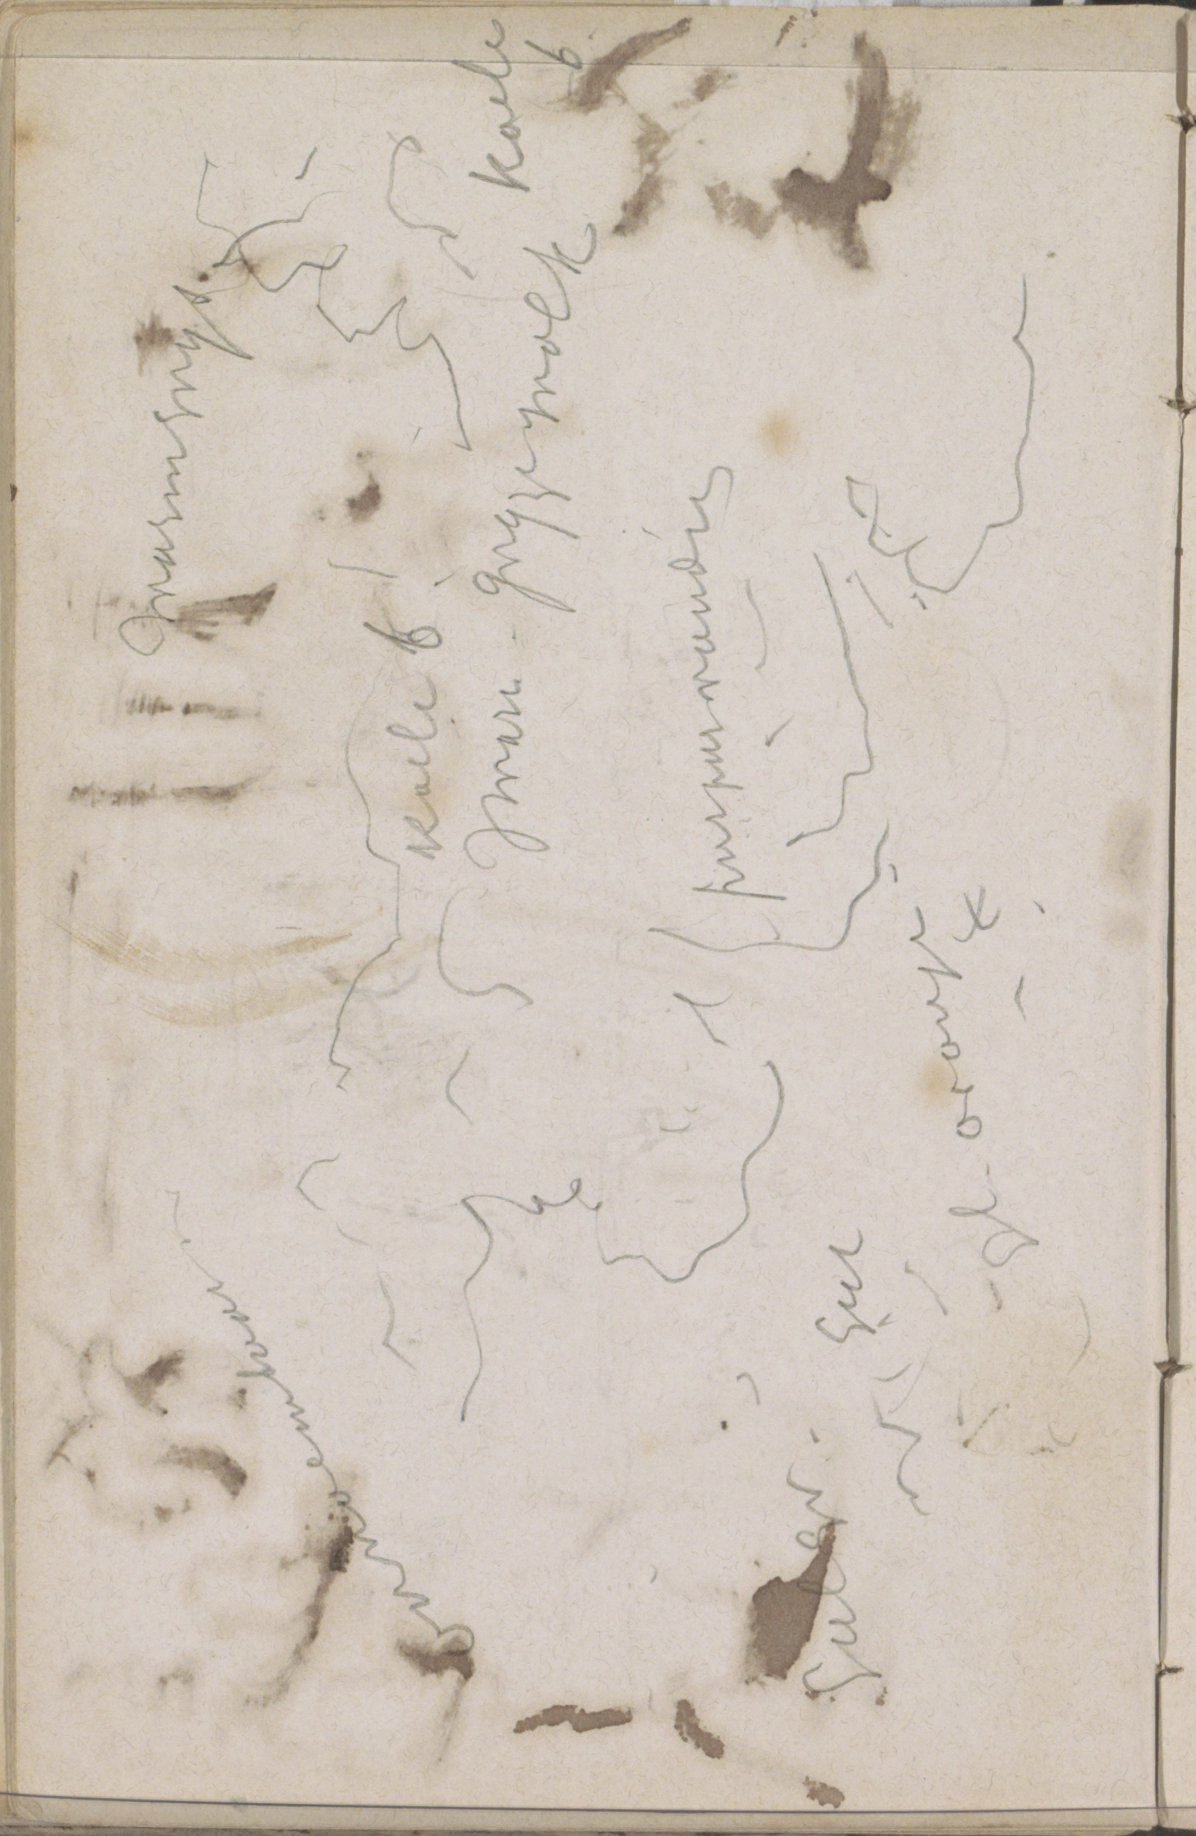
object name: sketchbook leaf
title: Wolken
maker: johannes tavenraat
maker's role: draughtsman, painter, print maker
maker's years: 1809-1881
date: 1862-1864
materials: paper, pencil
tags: clouds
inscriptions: kleurnotitie, handgeschreven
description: Blad 45 verso uit een schetsboek met 65 bladen.